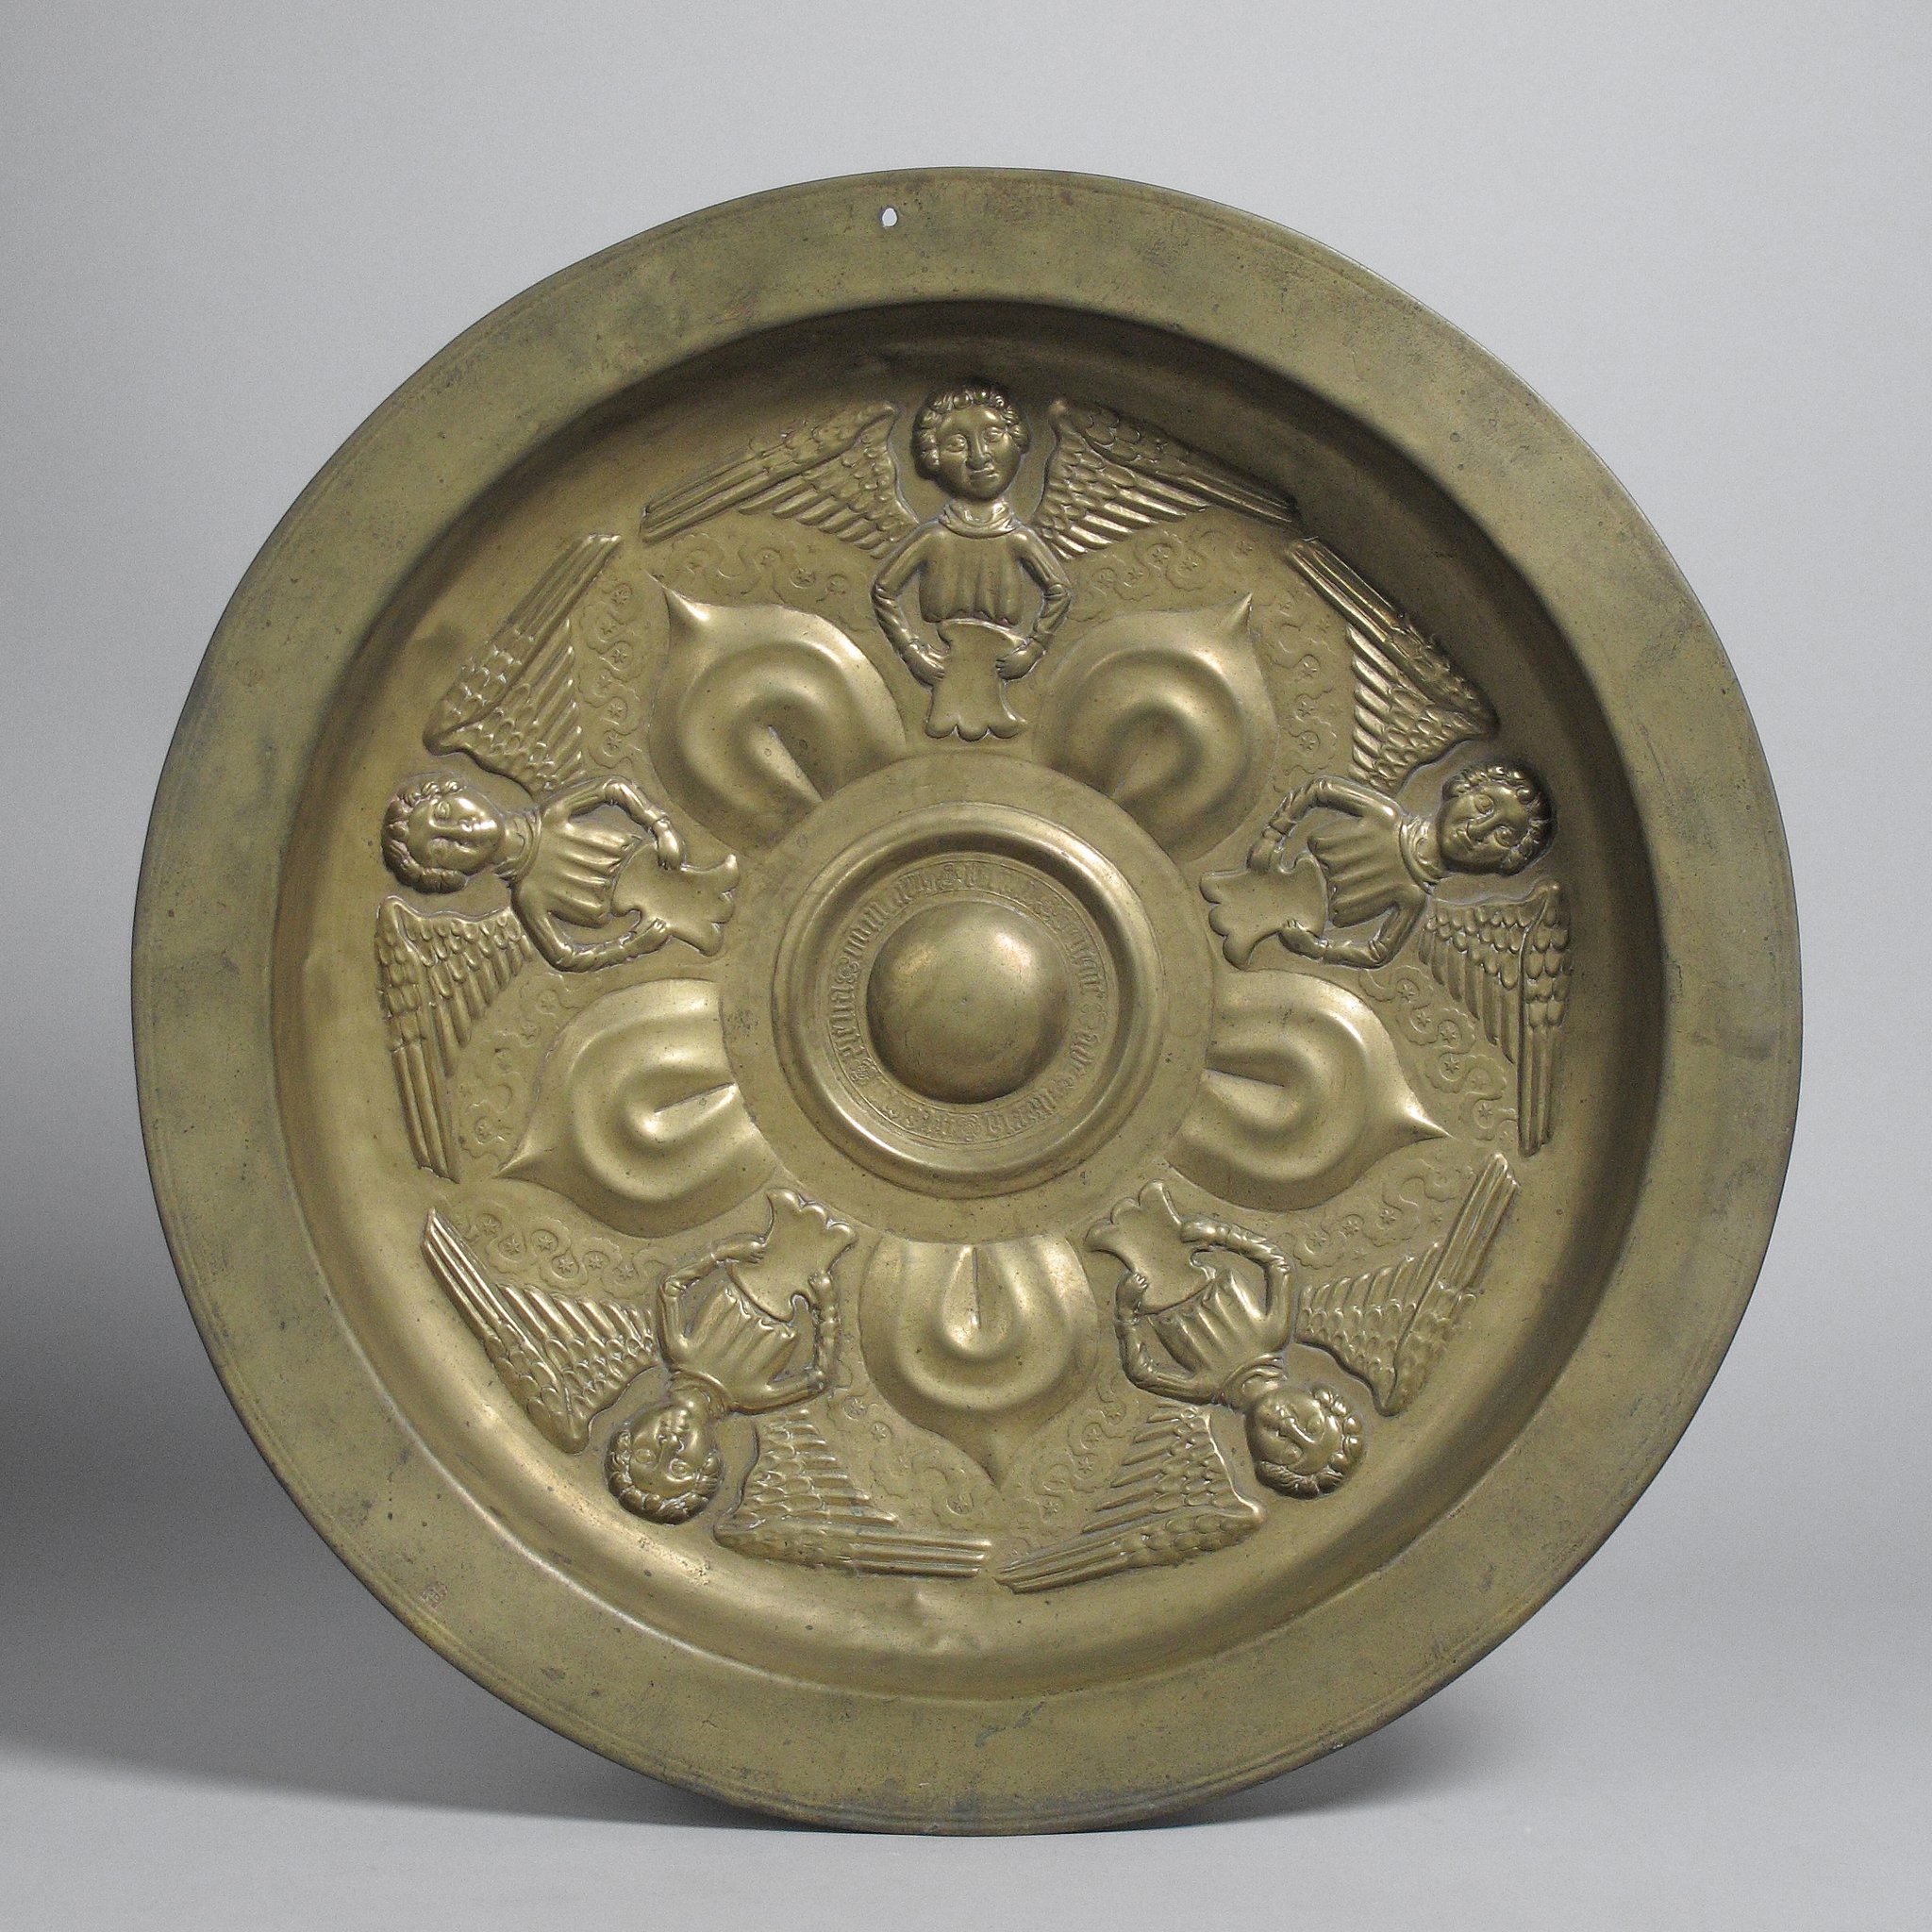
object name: plate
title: Plate with Five Angels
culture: german or south netherlandish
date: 1475-1500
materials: copper alloy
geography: germany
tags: angels